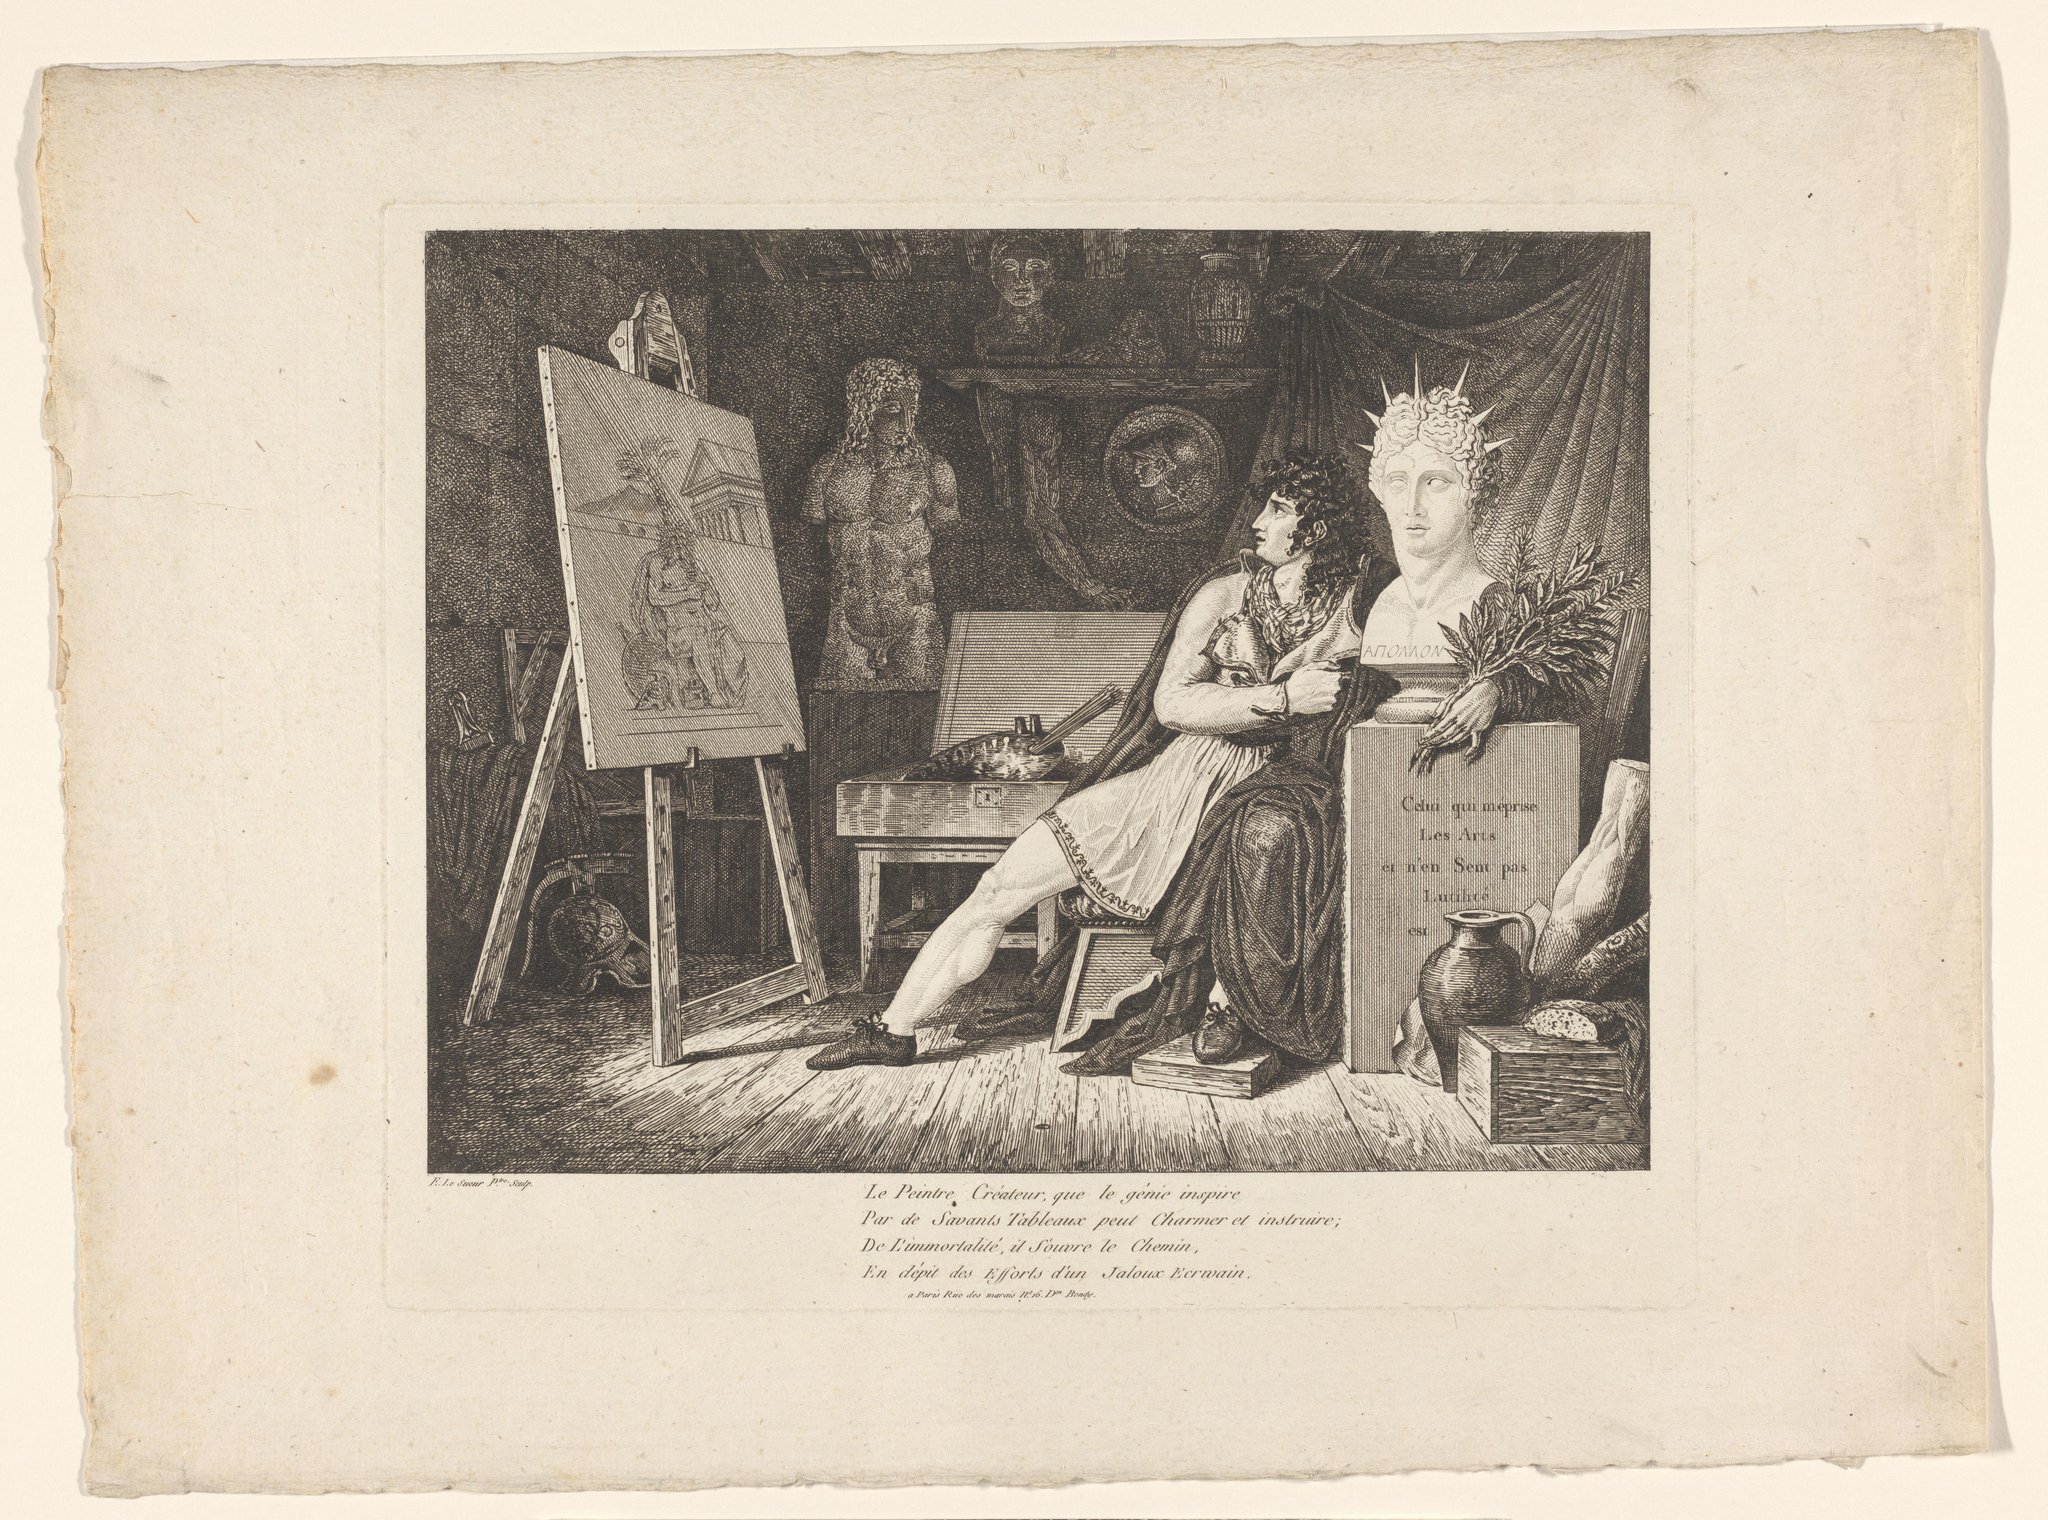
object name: print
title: Spotprent op een kunstcriticus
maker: pierre etienne lesueur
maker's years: 1760-1802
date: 1795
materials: ink, paper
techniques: etching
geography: paris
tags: criticizing and discussing art, art criticism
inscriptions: collector's mark: Lugt 2760, collector's mark: Lugt 2228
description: Allegorische verbeelding van het atelier van een neoclassicistische kunstenaar (Jacques Louis David) met een spottende verwijzing naar kunstcriticus Louis-Sébastien Mercier: Celui qui méprise les arts et n’en sent pas l’utilité est [une cruche].